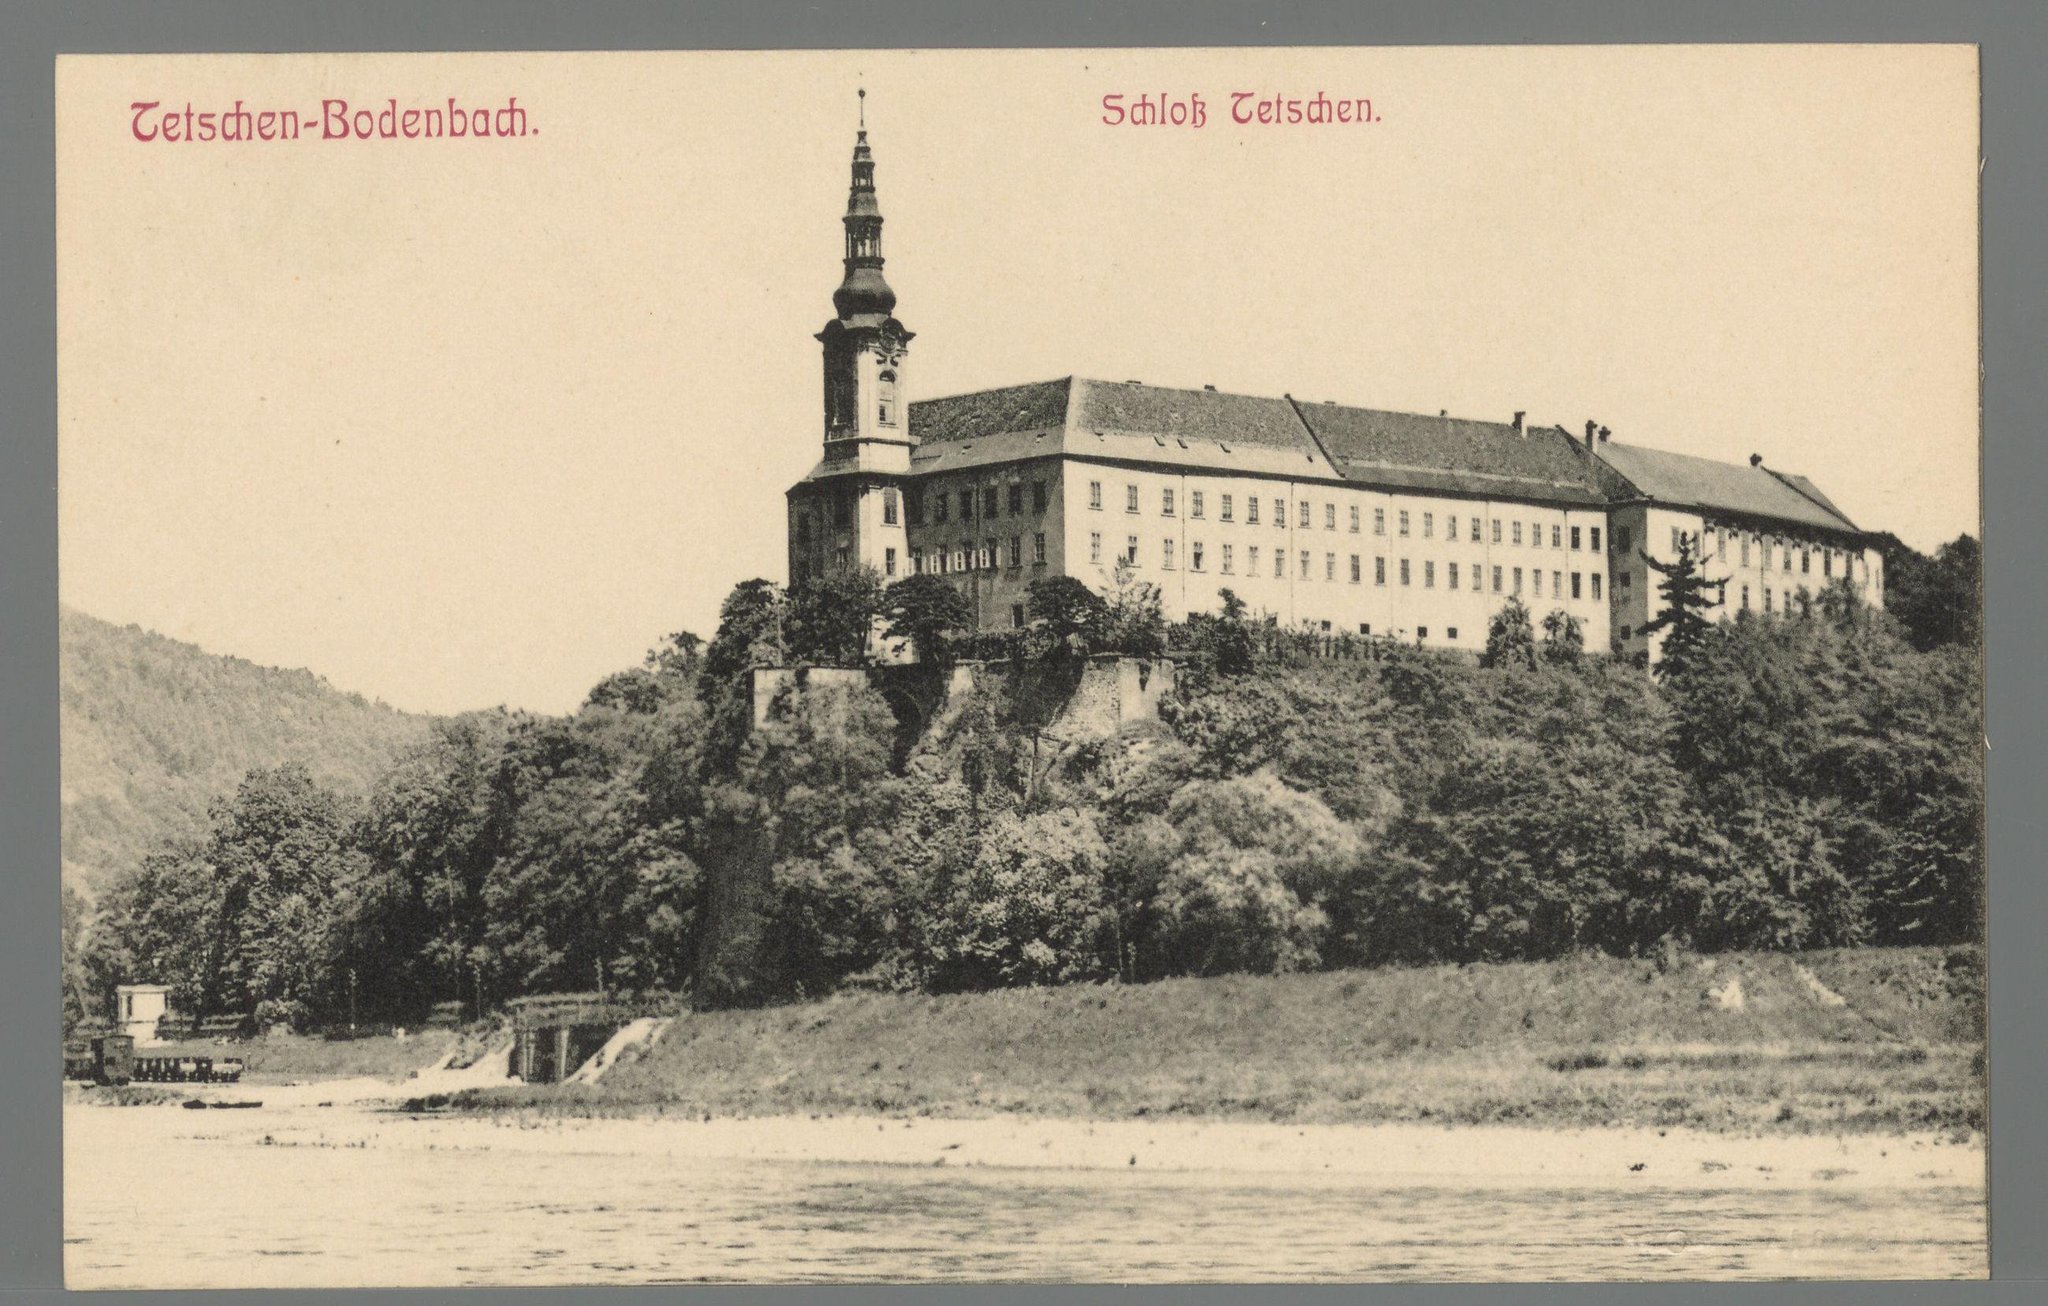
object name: photomechanical print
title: Tetschen-Bodenbach. Schloβ Tetschen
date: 1906-1930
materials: cardboard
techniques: photograph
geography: vienna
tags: castle, canals, waters (in city)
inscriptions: check stamp: ‘"Austria"’